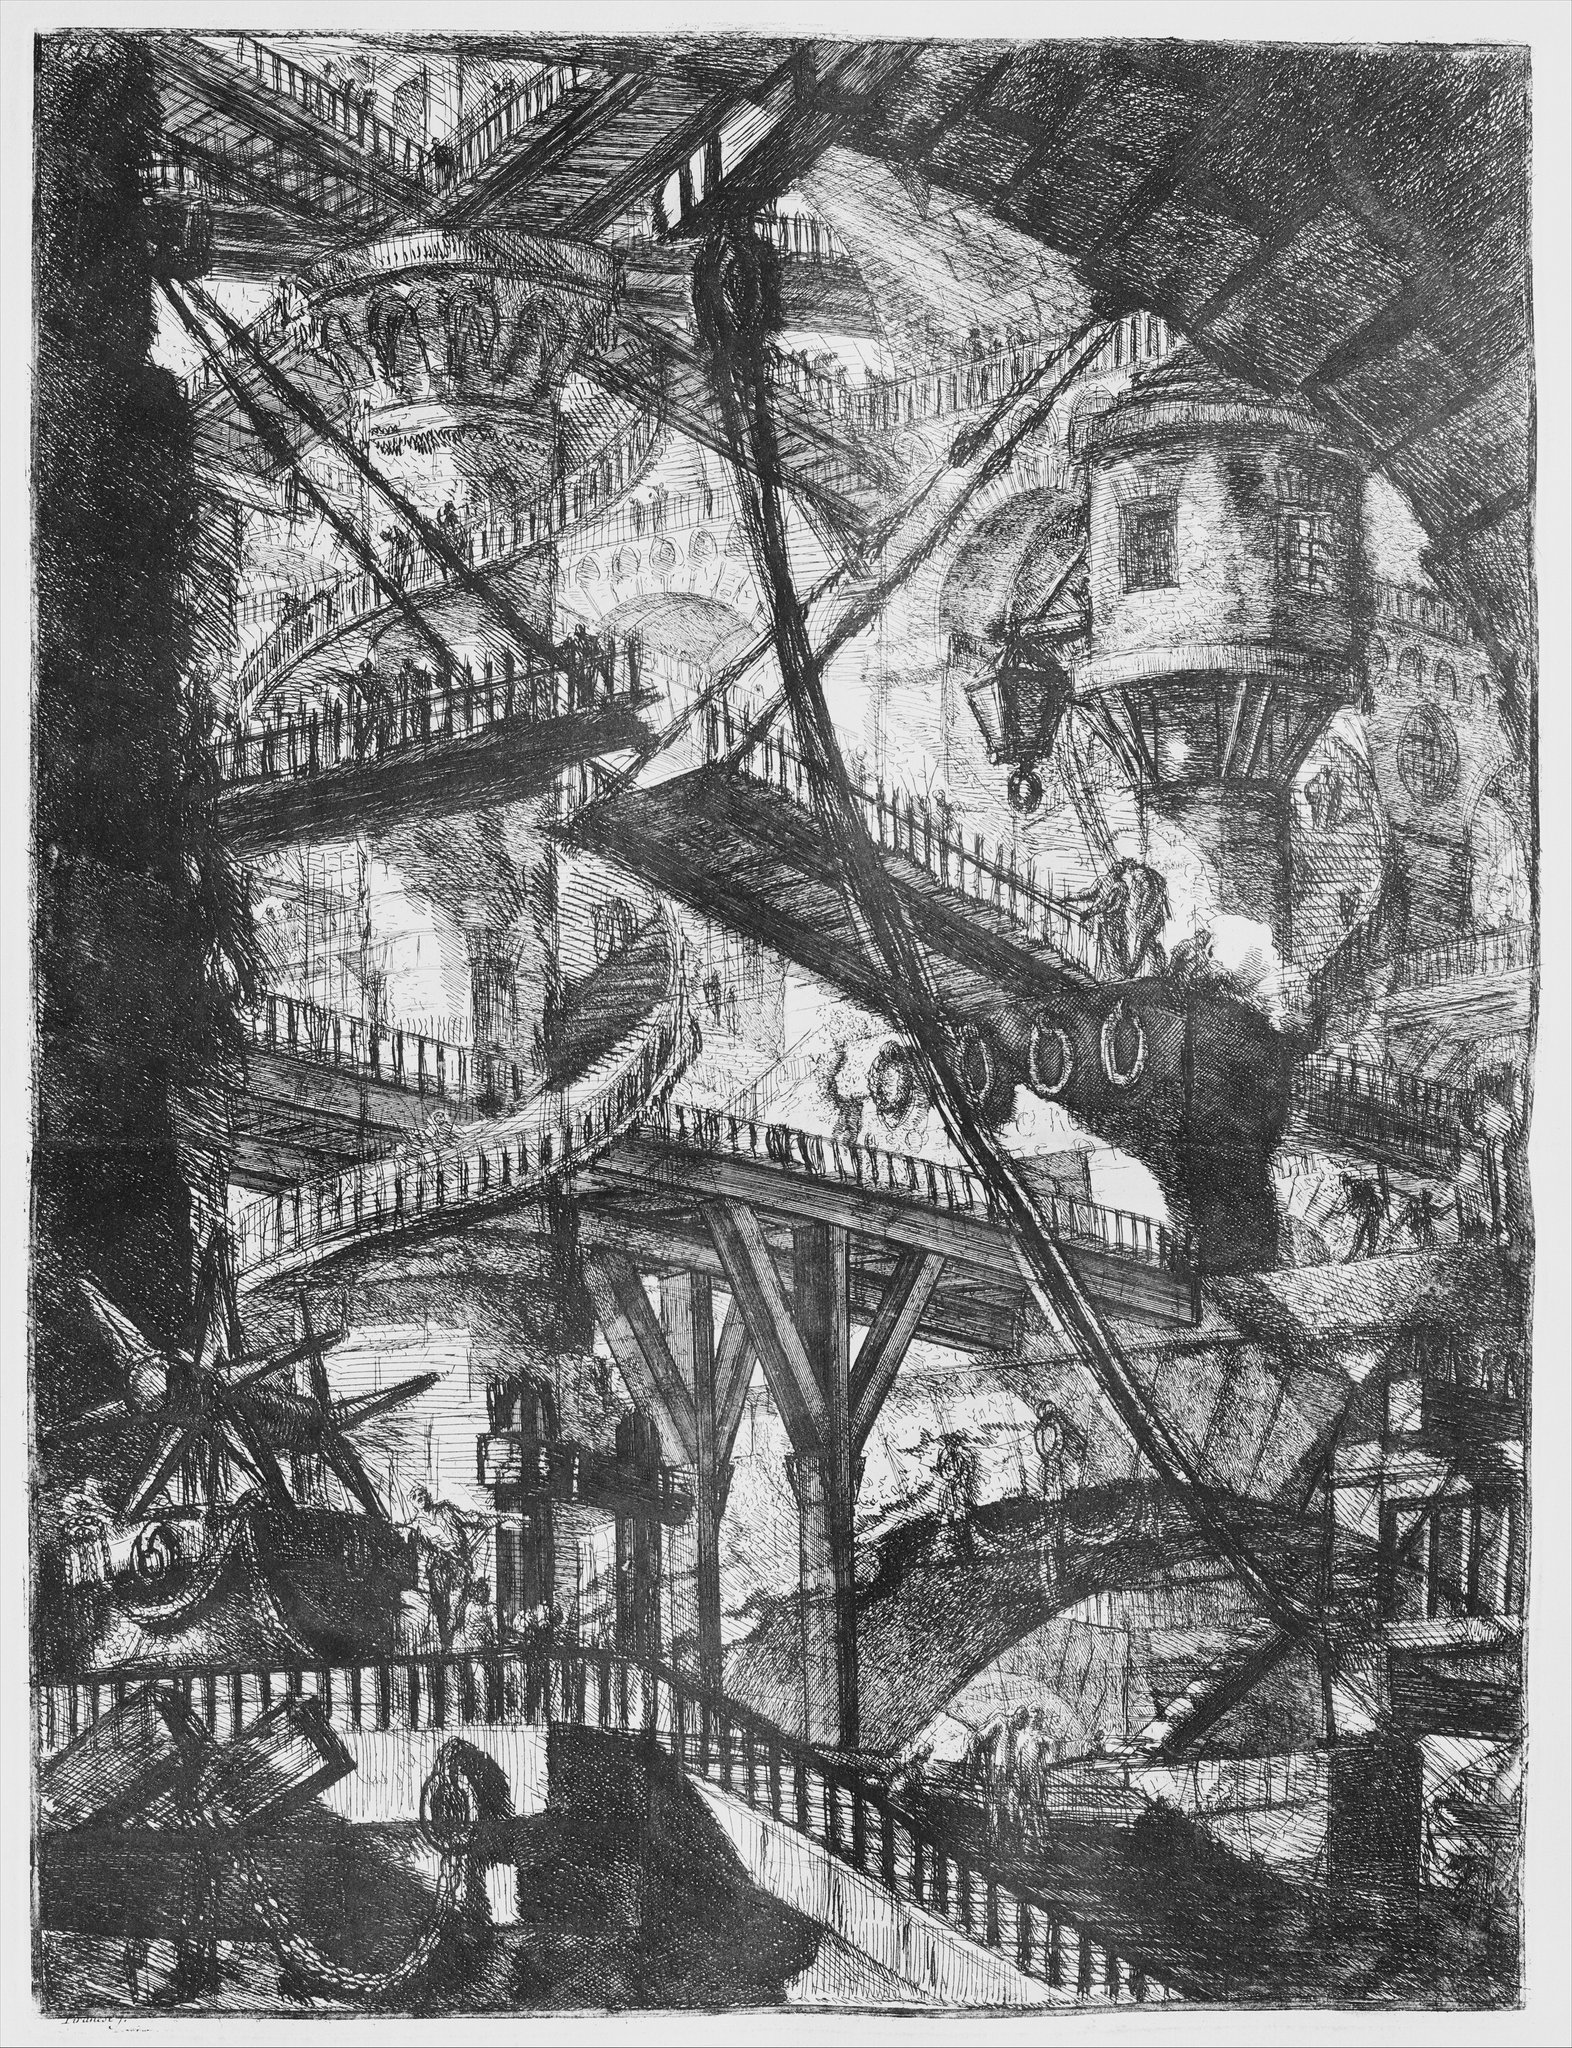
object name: album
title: Prima Parte di Architettura, e Prospettive inventate, ed incise da Giambatista Piranesi Architetto Veneziano fra gli Arcadi Salcindio Tiseio; Lettere di Giustificazione a Milord Charlemont plates, which were adapted to appear in the Opere Varie; Opere Varie; Grotteschi; Carceri; Archi Trionfali, and Trofei di Ottaviano Augusto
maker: giovanni battista piranesi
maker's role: artist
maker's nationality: italian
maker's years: 1720-1778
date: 1761-1809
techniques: etching